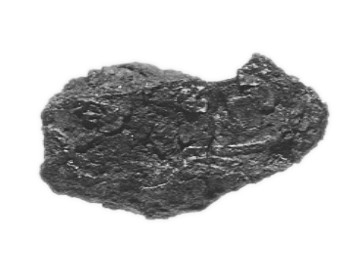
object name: sealing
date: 2030-1640 BCE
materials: clay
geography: egypt